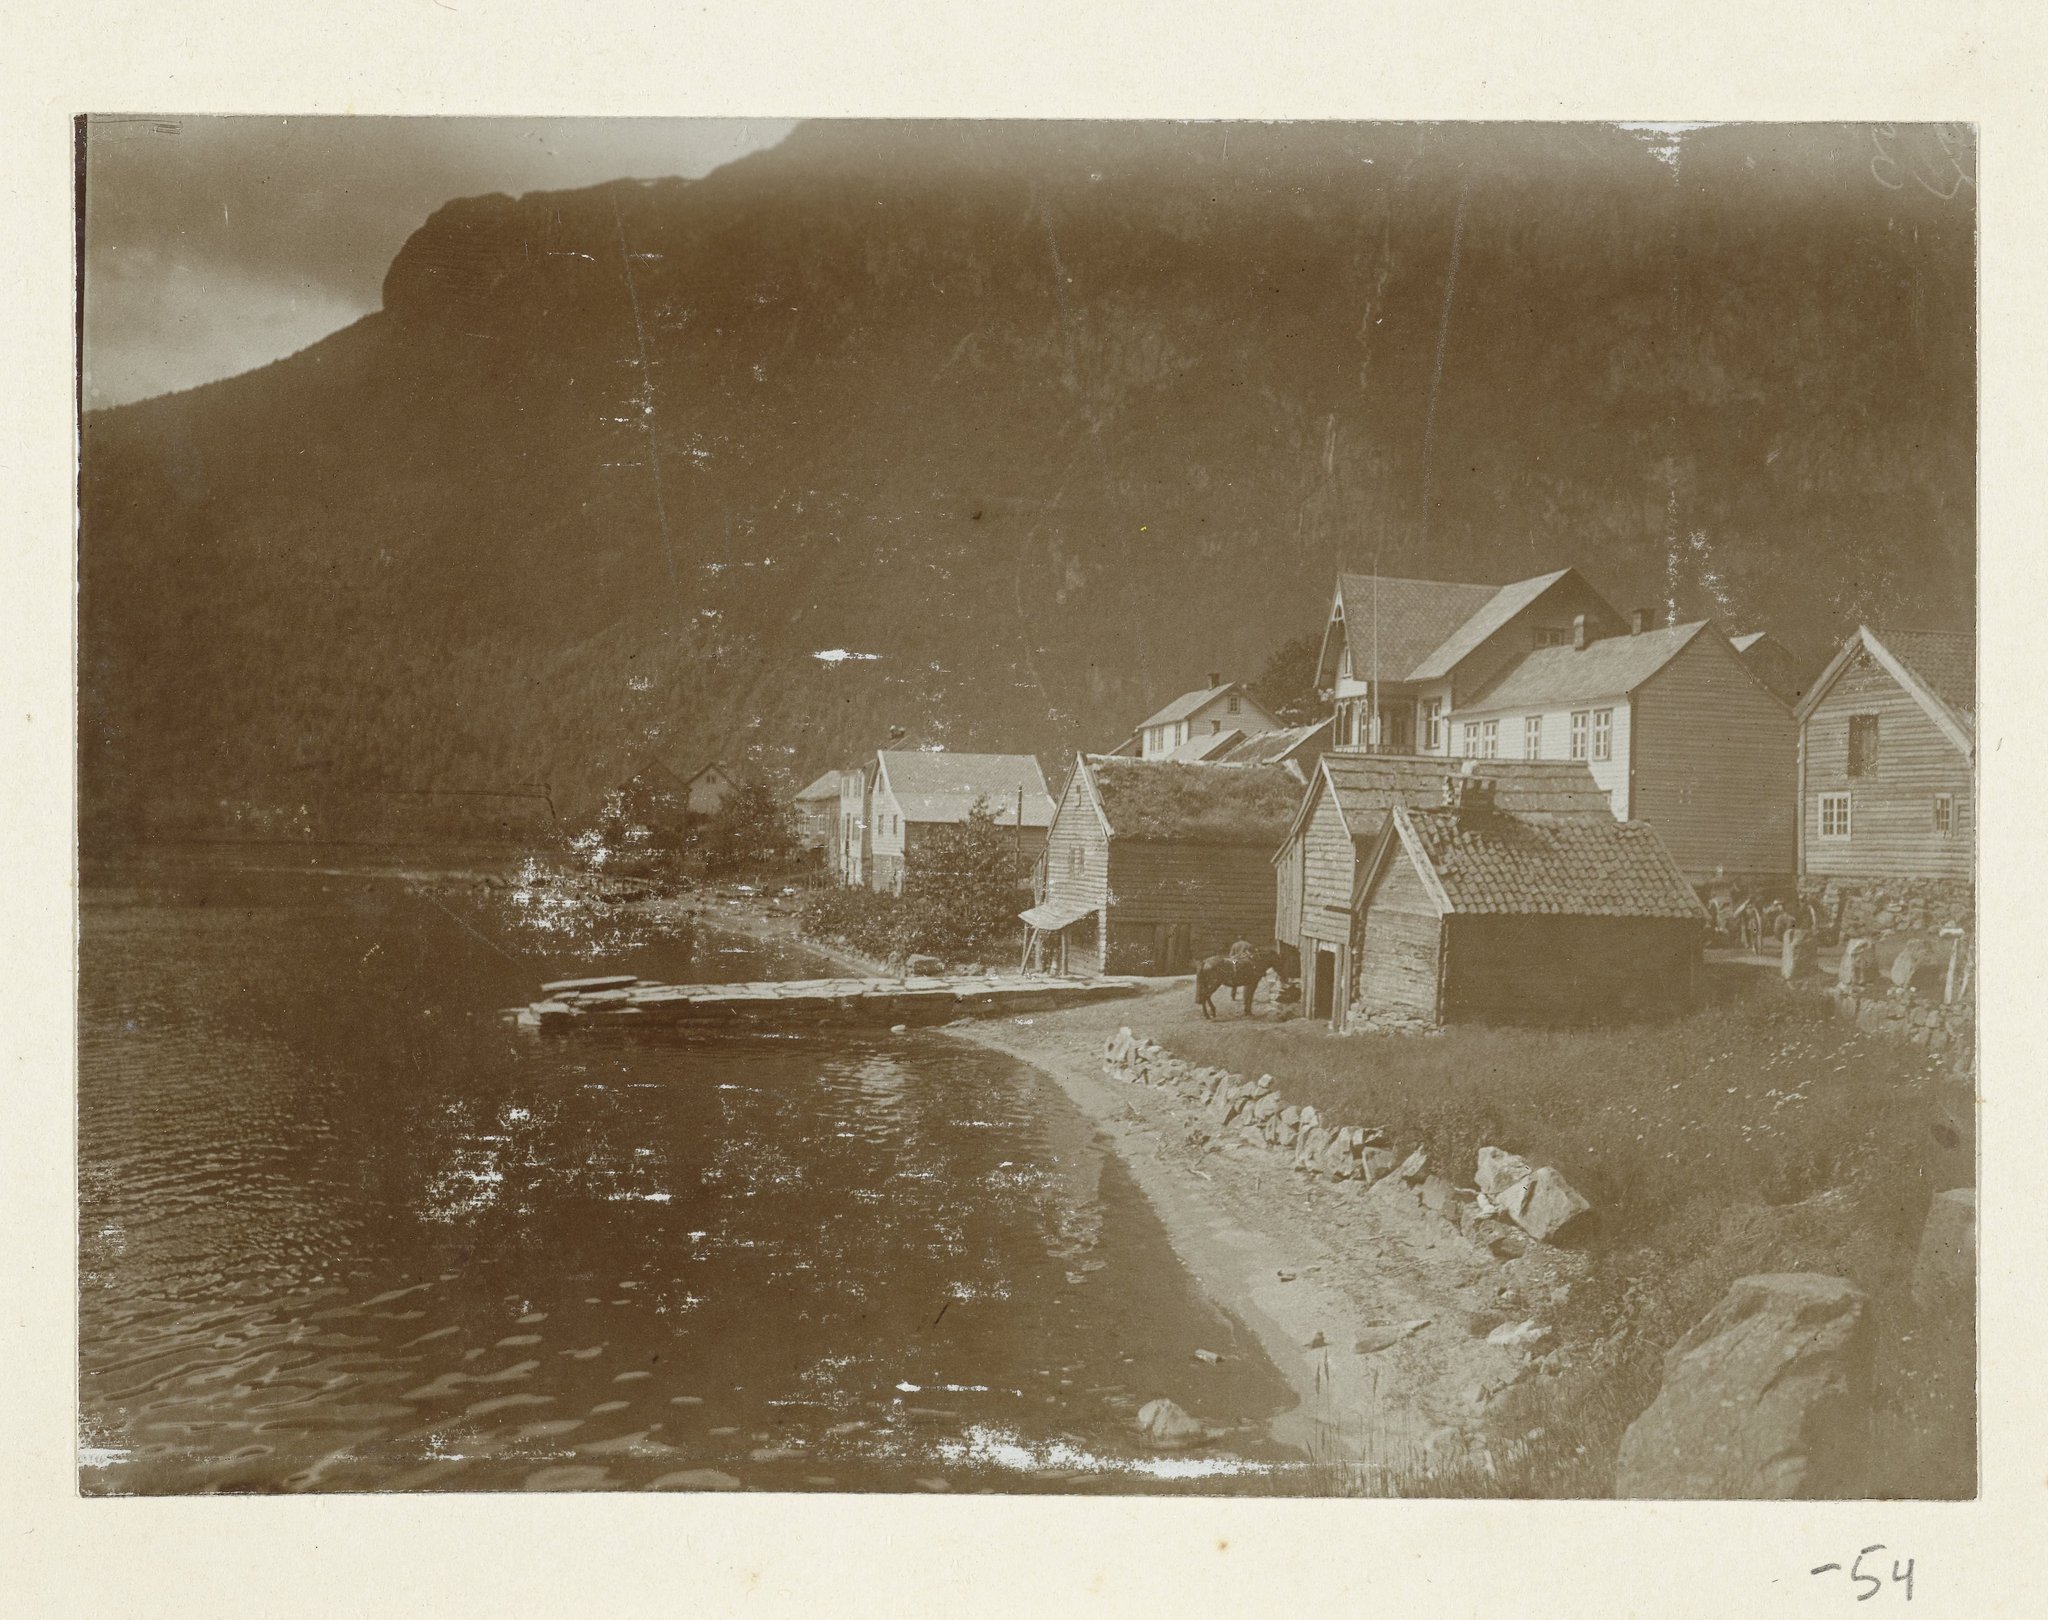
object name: photograph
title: Gezicht op een dorpje met houten huizen gelegen aan het water, vermoedelijk in de Harz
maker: geldolph adriaan kessler (dolph)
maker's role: fotograaf, industrieel, voetballer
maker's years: 1884-1945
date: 1903-1908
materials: cardboard, photographic support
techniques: collodion silver print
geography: harz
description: Gezicht op een dorpje met houten huizen gelegen aan het water, vermoedelijk in de Harz. Onderdeel van het fotoalbum van Dolph Kessler met opnamen die hij maakte tijdens zijn verblijf in Engeland en op een wereldreis die hij als secretaris van Henri Deterding (directeur Koninklijke Olie) ondernam naar Nederlands-Indië, Japan, China en de Verenigde Staten, tussen 1906 en 1908.